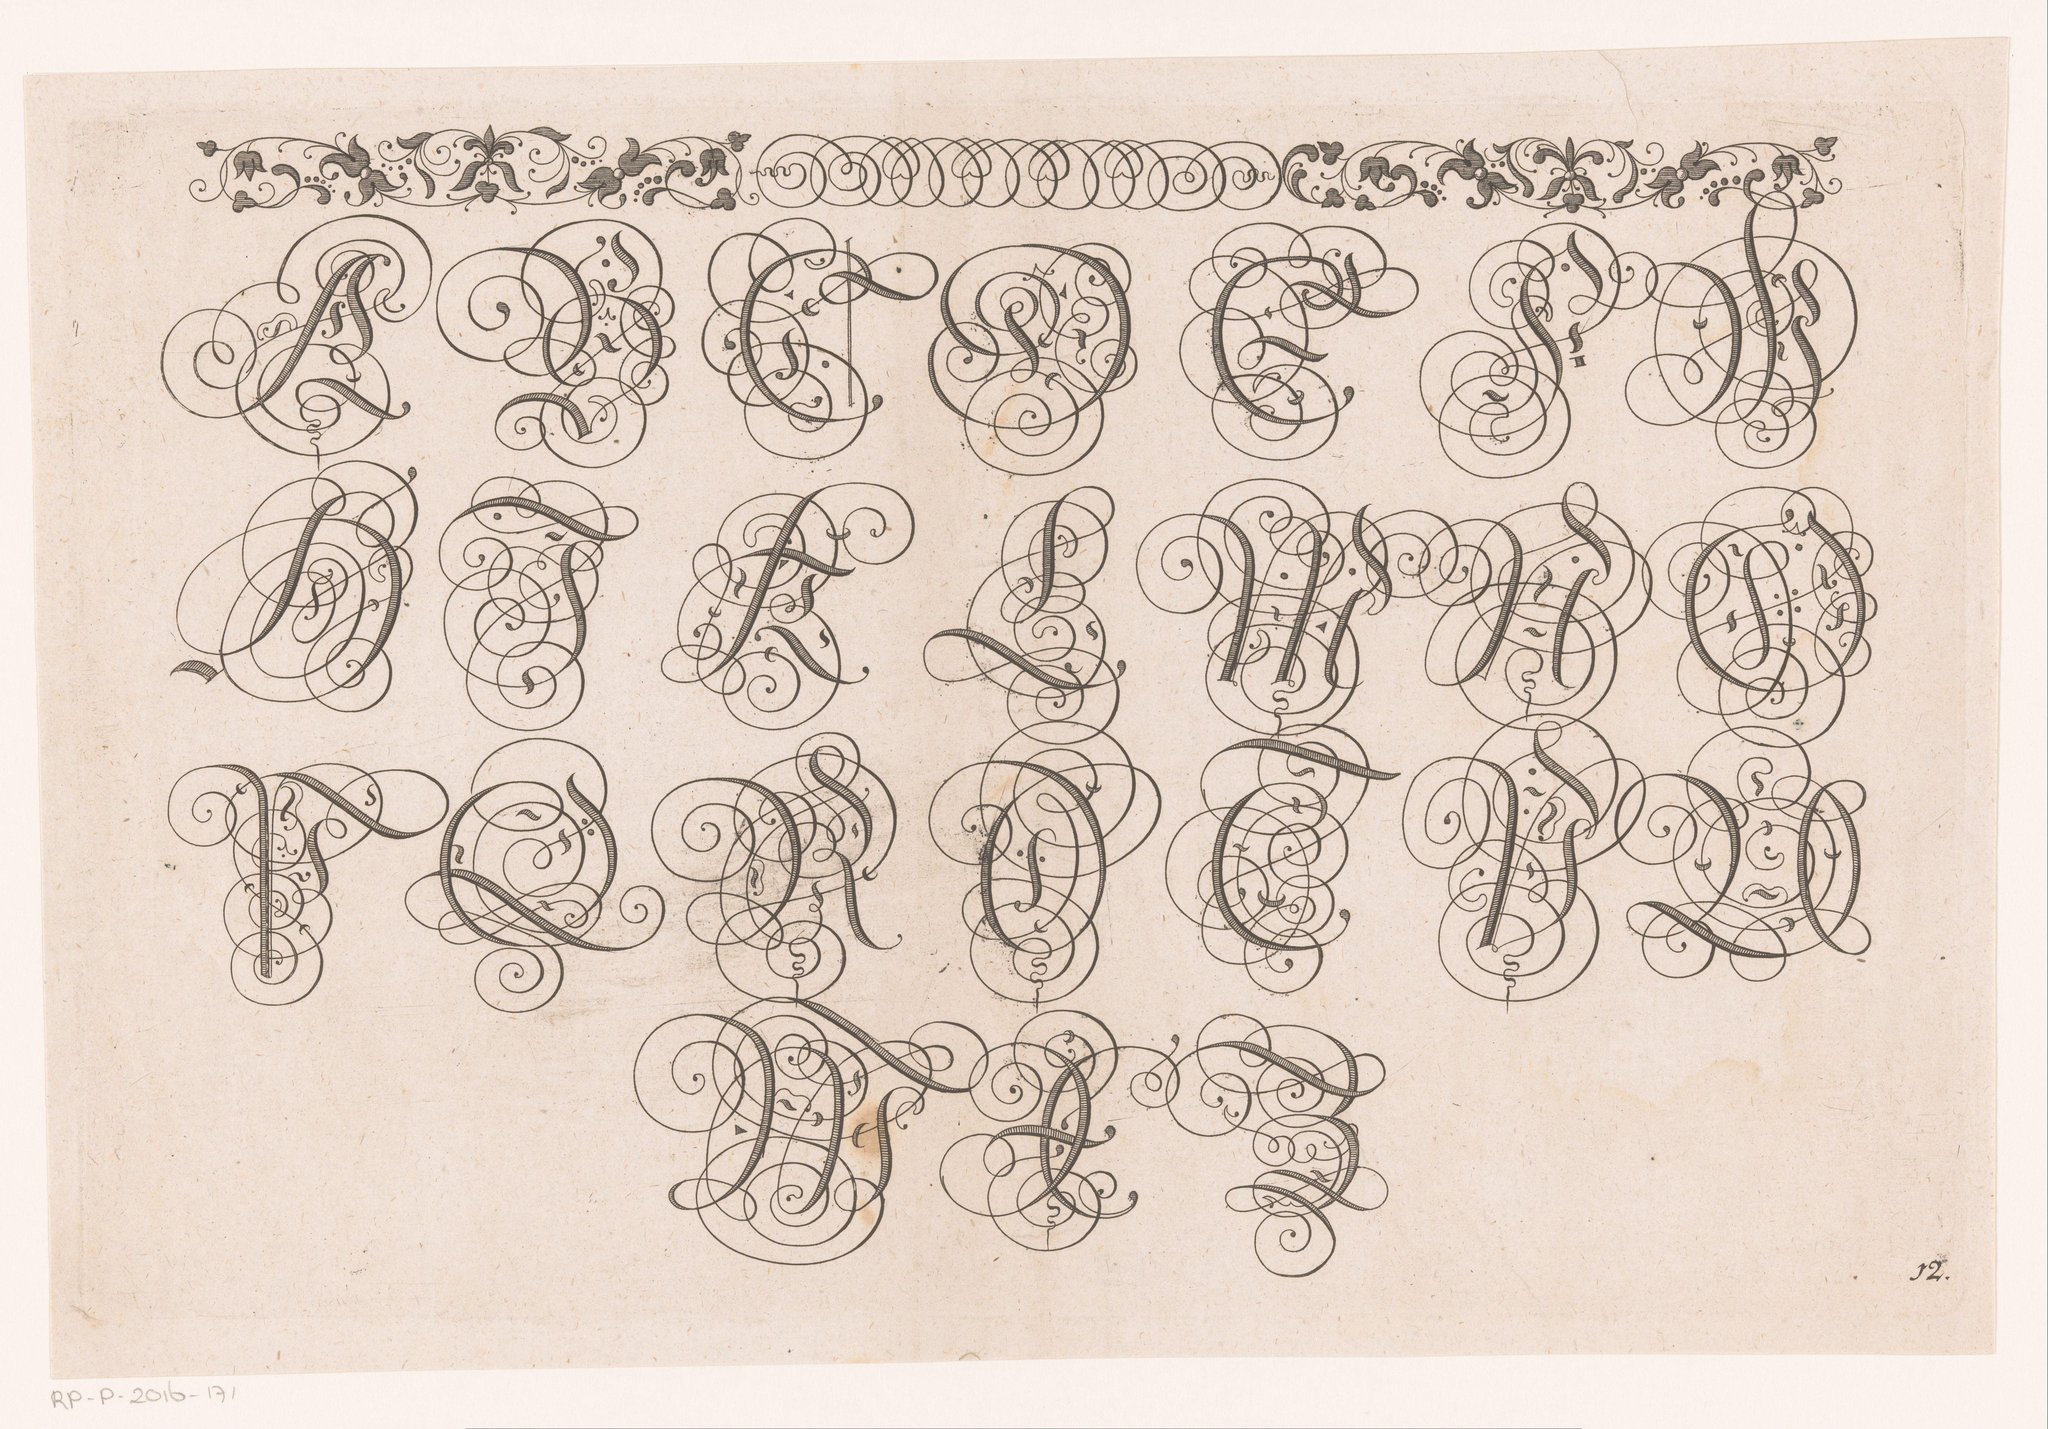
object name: print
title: Kalligrafie voorbeelden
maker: johann jacob losenauer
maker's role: print maker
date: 1695-1790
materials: paper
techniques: engraving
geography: stuttgart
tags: calligraphy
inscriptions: collector's mark: Lugt 2228